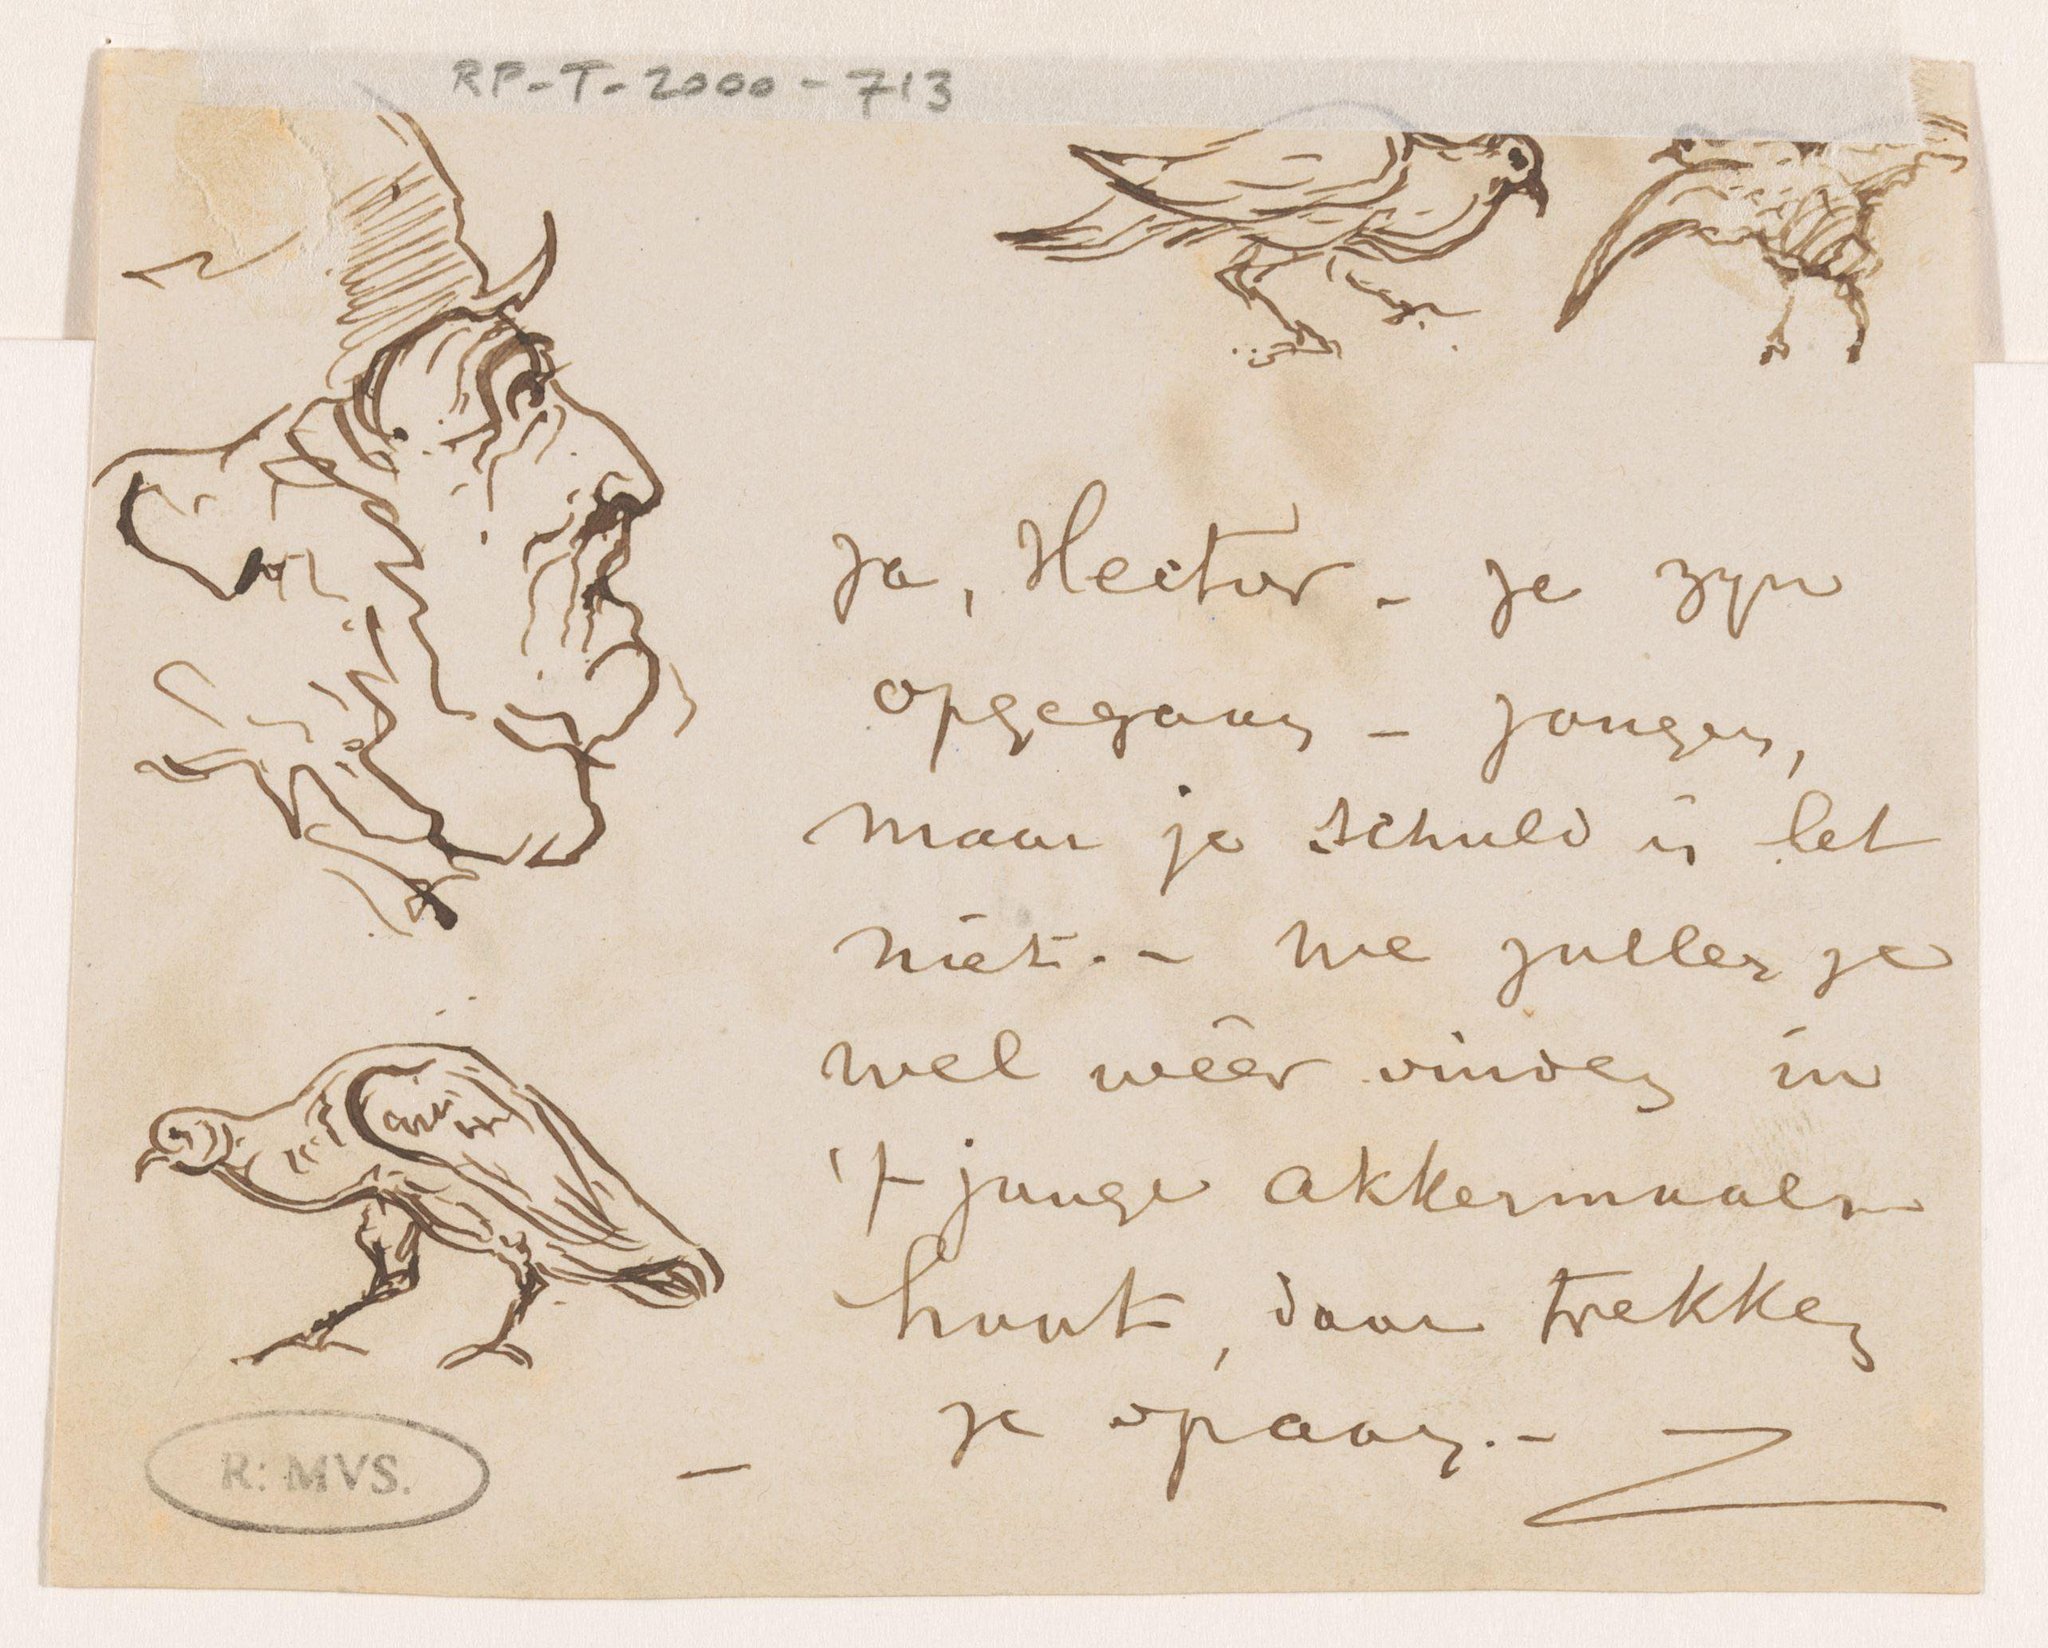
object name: drawing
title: Kop en vogels, met tekstje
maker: johannes tavenraat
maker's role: draughtsman, painter, print maker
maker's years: 1809-1881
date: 1840-1880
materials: ink, paper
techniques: pen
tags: hunting dogs, birds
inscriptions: collector's mark: Lugt 2228, annotation: ‘Ja, Hector- ze zijn opgegaan ... daar trekken ze tzaam.’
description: Kop en vogels, met een achtregelig tekstje over de hond en de vogels (zie voorzijde).